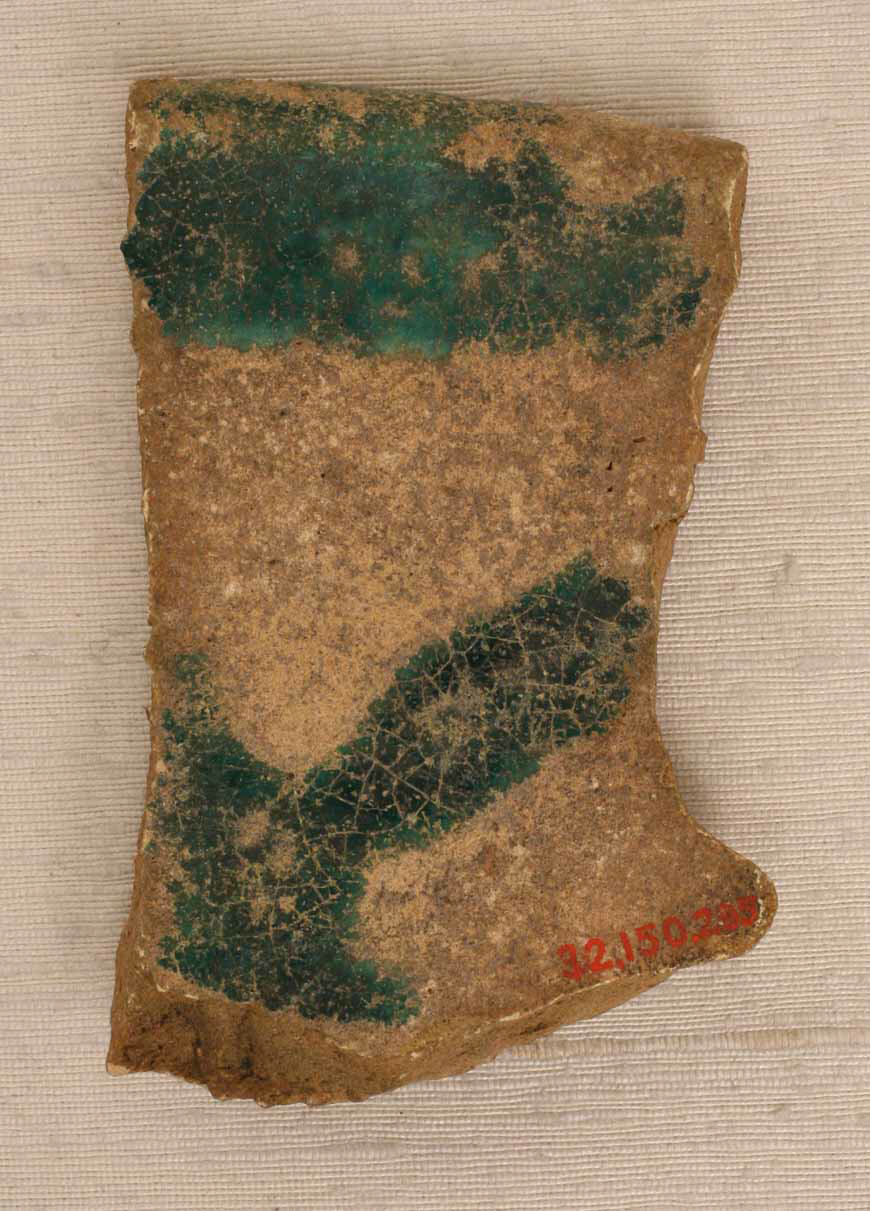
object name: fragment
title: Ceramic Fragment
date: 701-900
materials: earthenware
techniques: glazing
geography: iraq